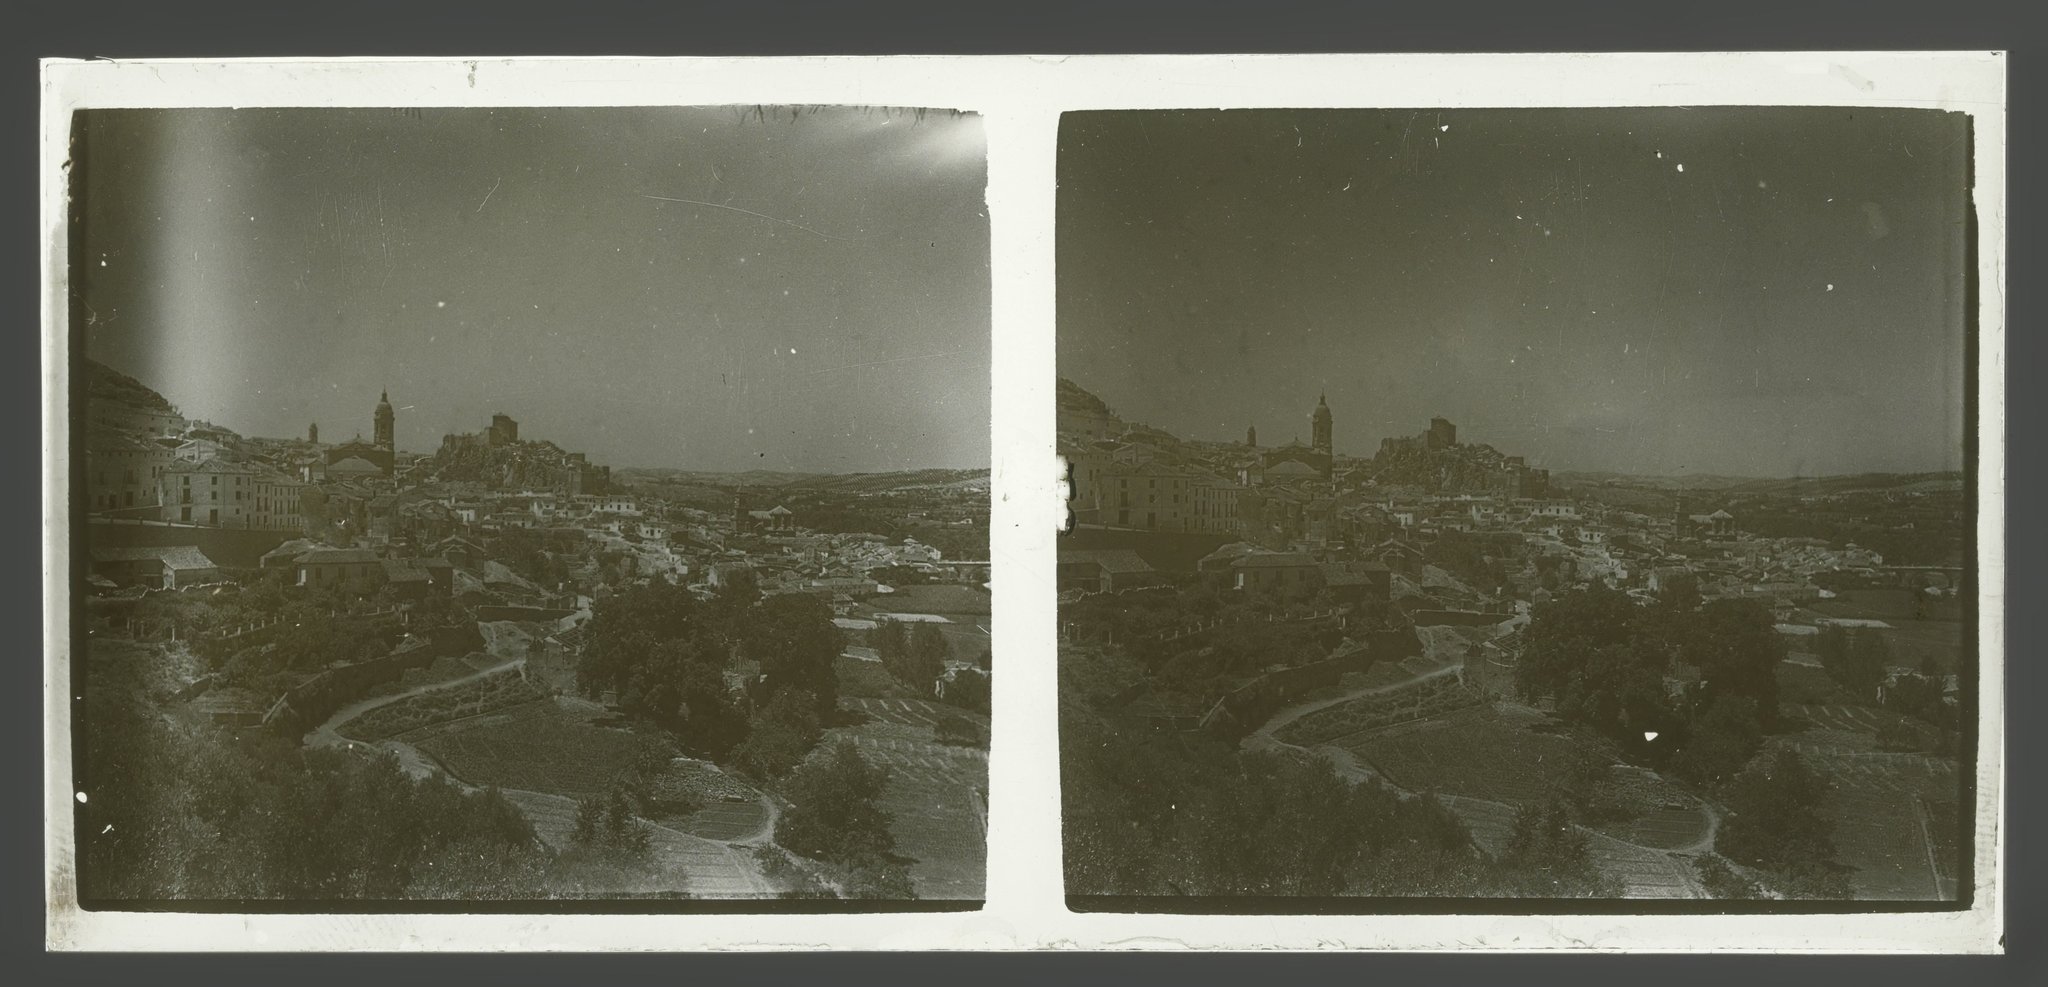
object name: stereoscopic photograph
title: Stad tegen berghelling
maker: Anonymous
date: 1851-1885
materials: glass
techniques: collodion process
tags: city-view in general; 'veduta'